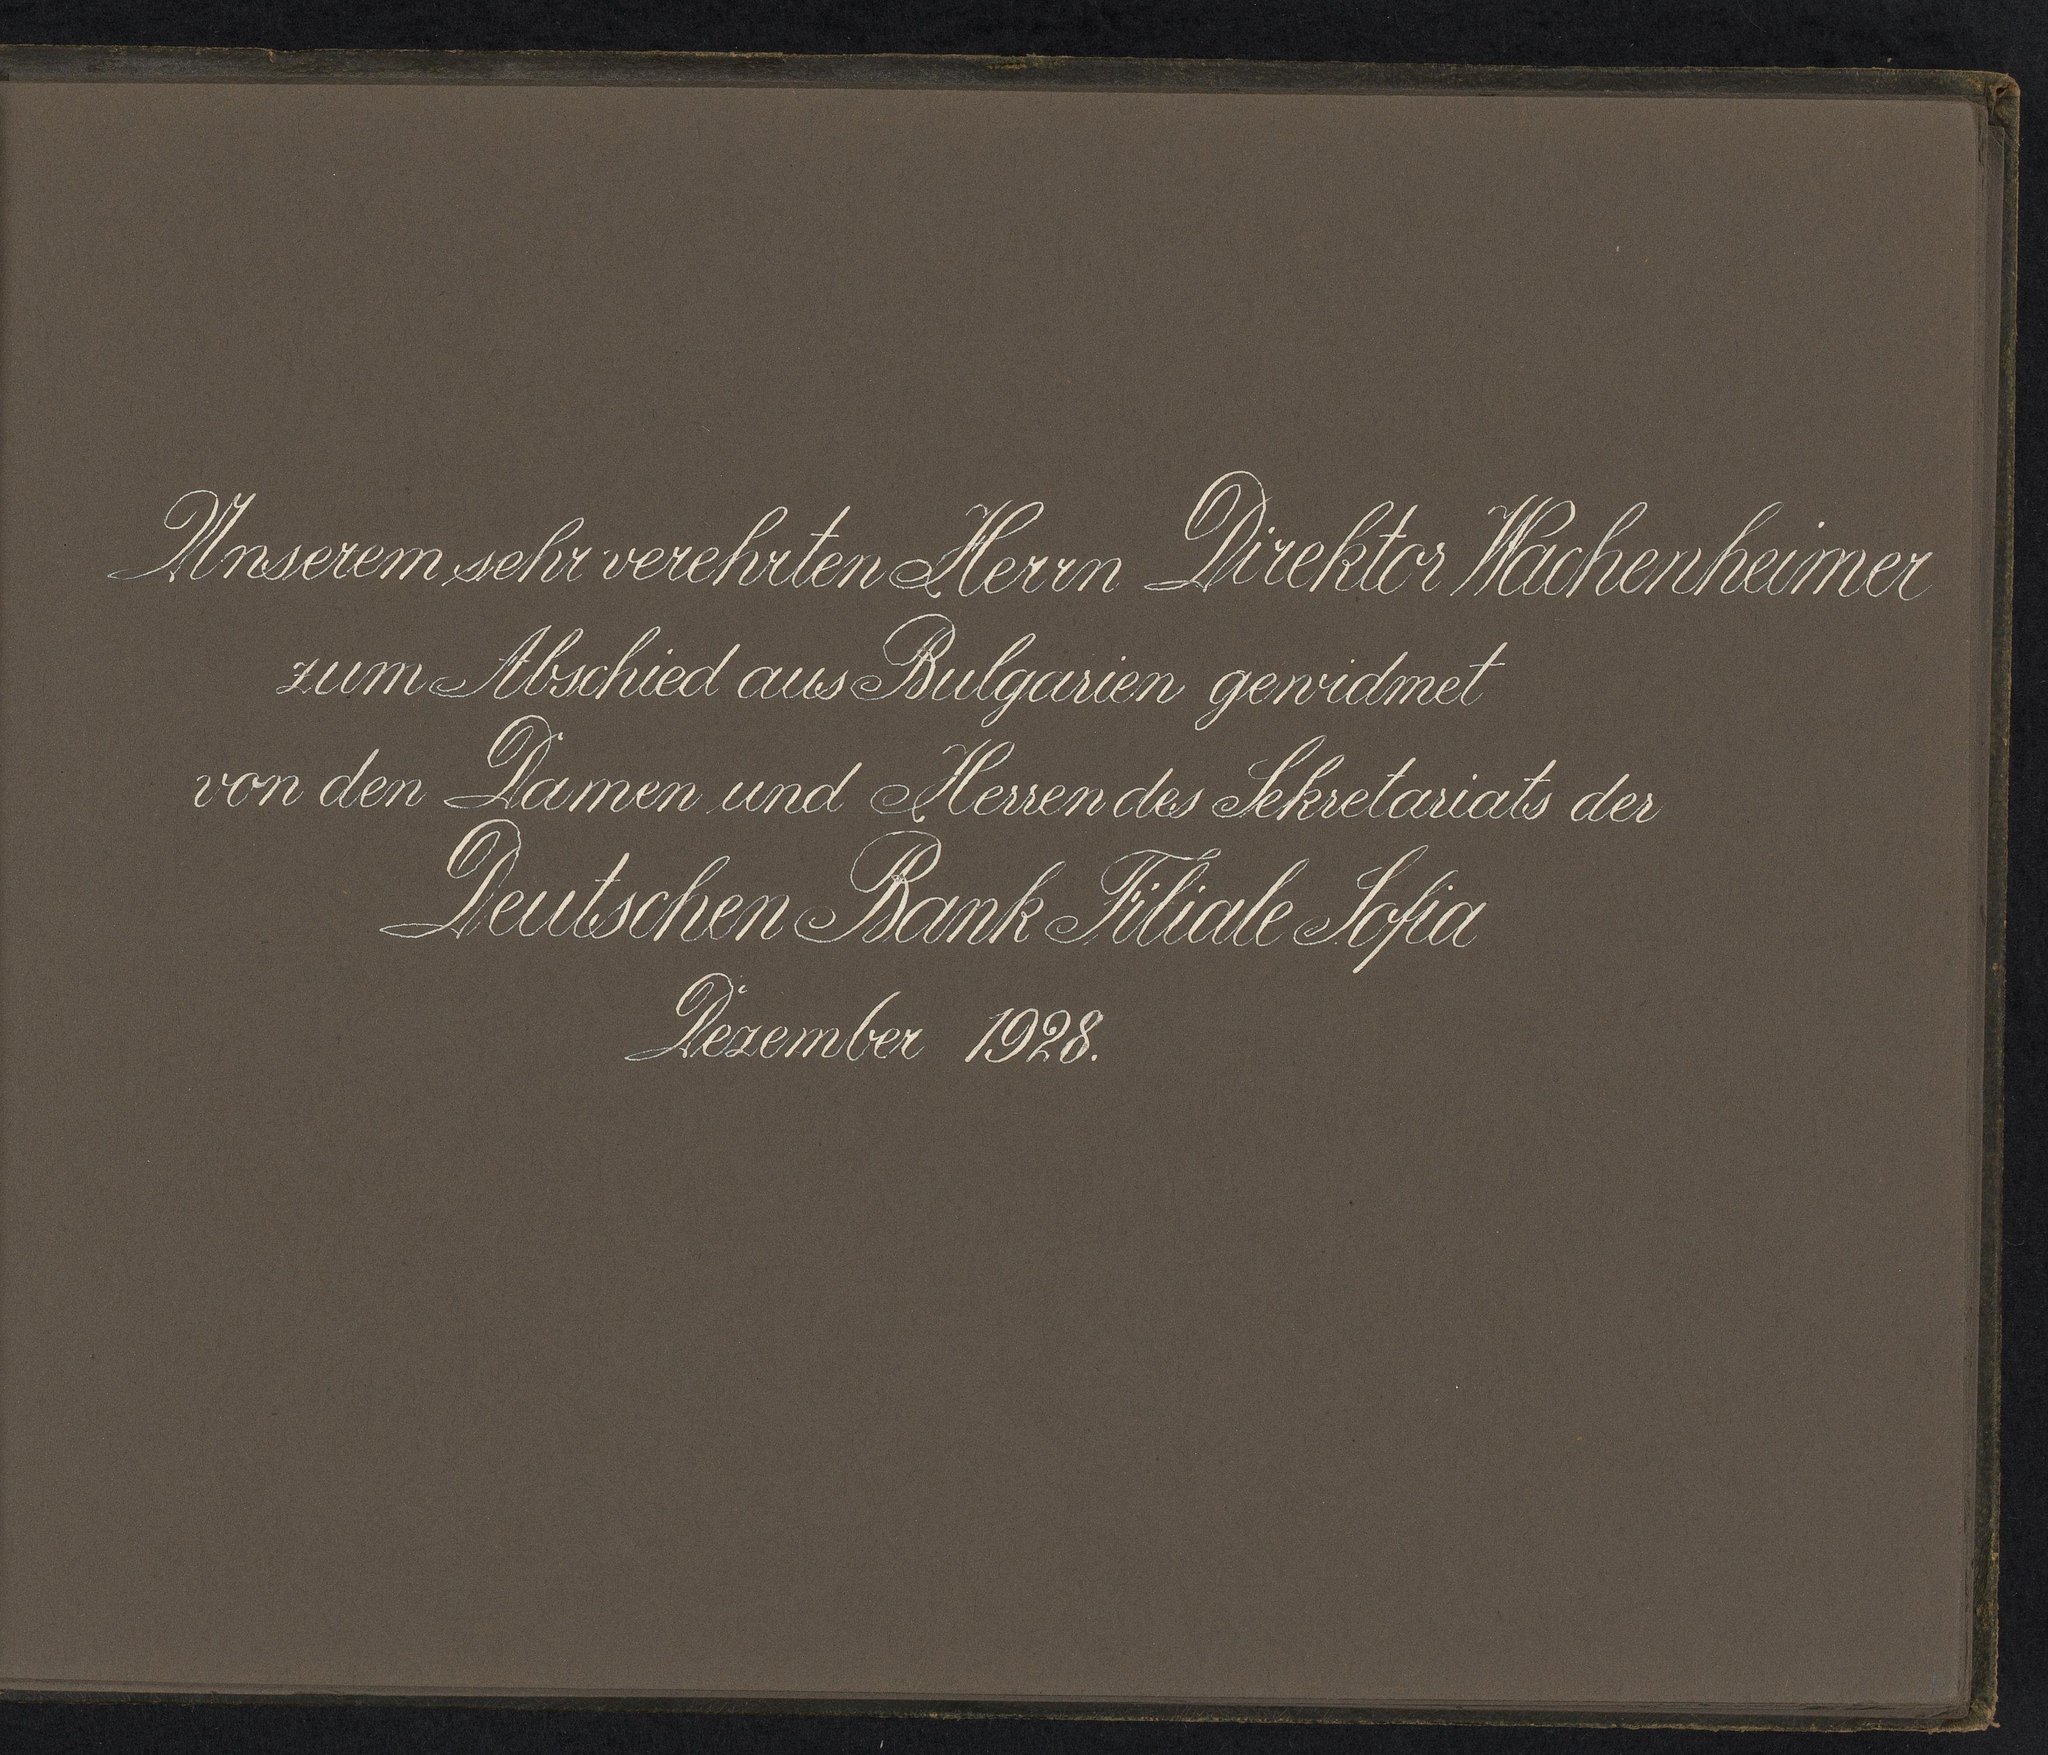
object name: album leaf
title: Handgeschreven opdracht bij het afscheid van Eugen Wachenheimer als directeur van het filiaal van de Deutsche Bank in Sofia, 1928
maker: Anonymous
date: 1912-1928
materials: cardboard, ink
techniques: pen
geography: sofia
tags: eugen wachenheimer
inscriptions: date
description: Handgeschreven opdracht voorin het album. Onderdeel van het fotoalbum voor Eugen Wachenheimer bij zijn afscheid als directeur van het filiaal van de Deutsche Bank in Sofia, december 1928.